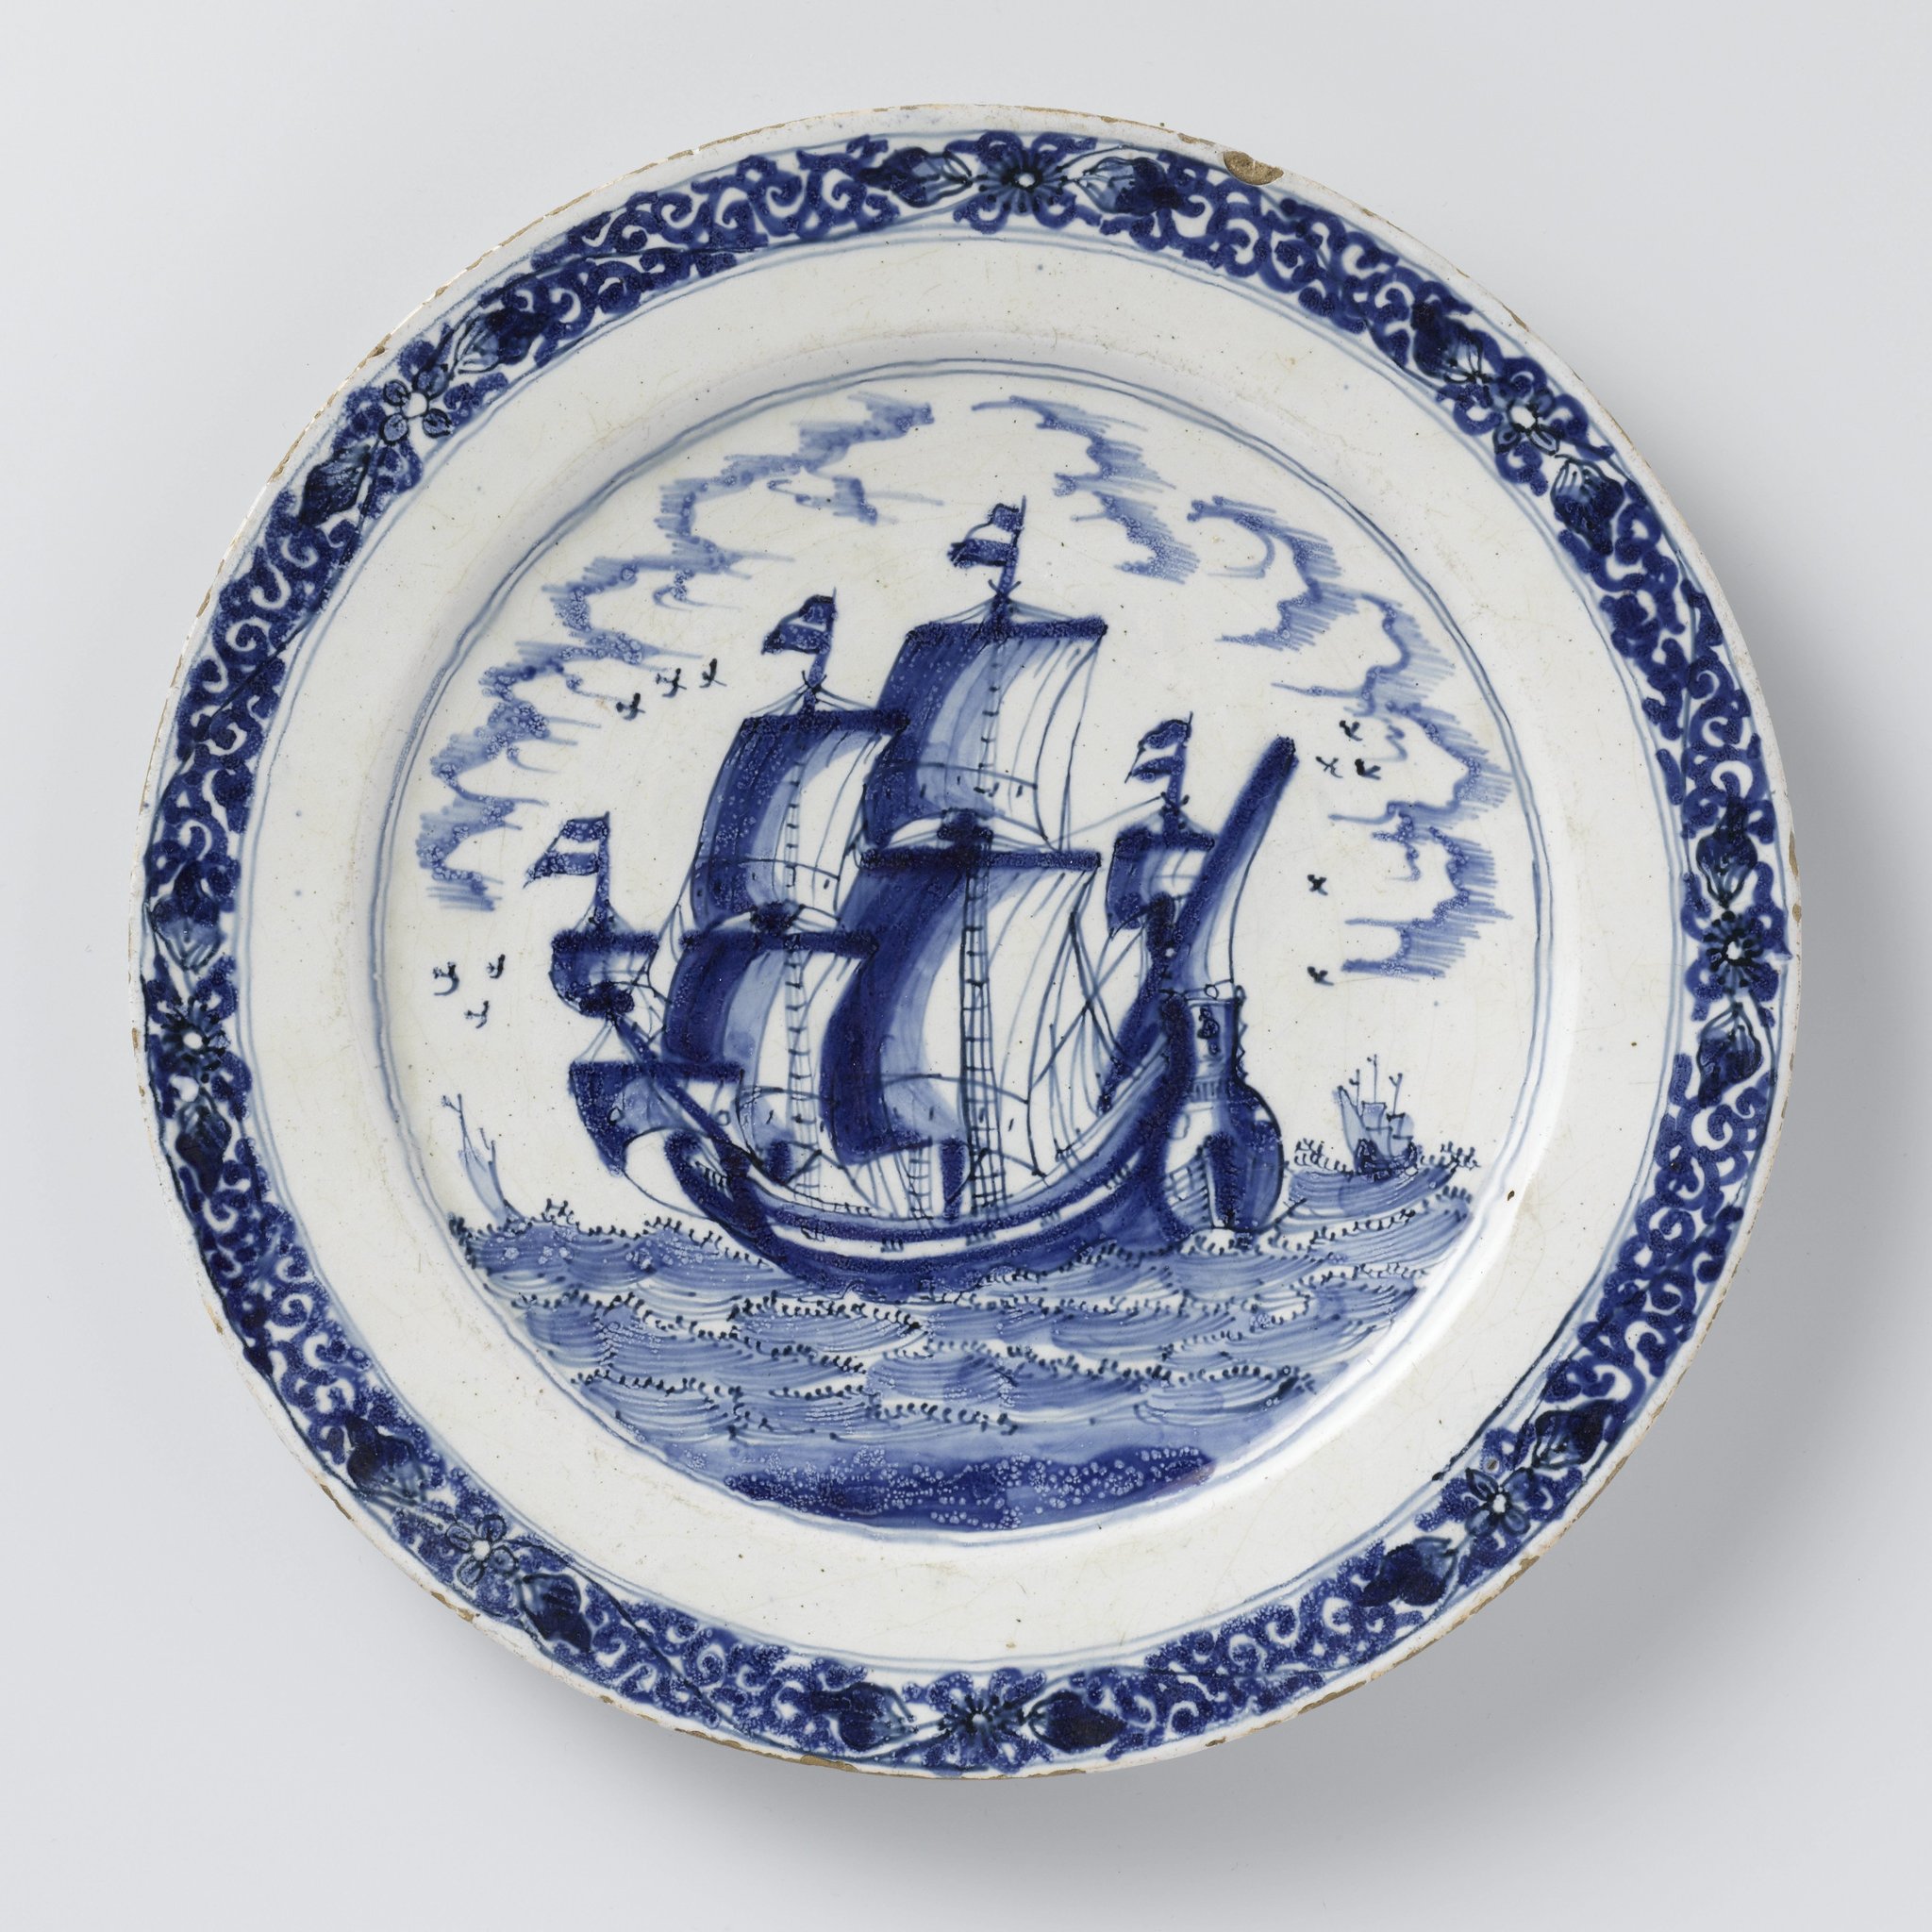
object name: plate dish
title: Bord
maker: Anonymous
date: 1680-1710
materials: earthenware, glaze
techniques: painted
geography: delft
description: Rond bord van blauw beschilderde faience, met op het plat vier zeilende schepen. Het bord is in 1967 in bruikleen gegeven aan het Goltzius Museum in Venlo. Bij het bord horen drie identieke borden met de invnrs. BK-NM-11168-b, BK-NM-11168-c en BK-NM-11168-d.